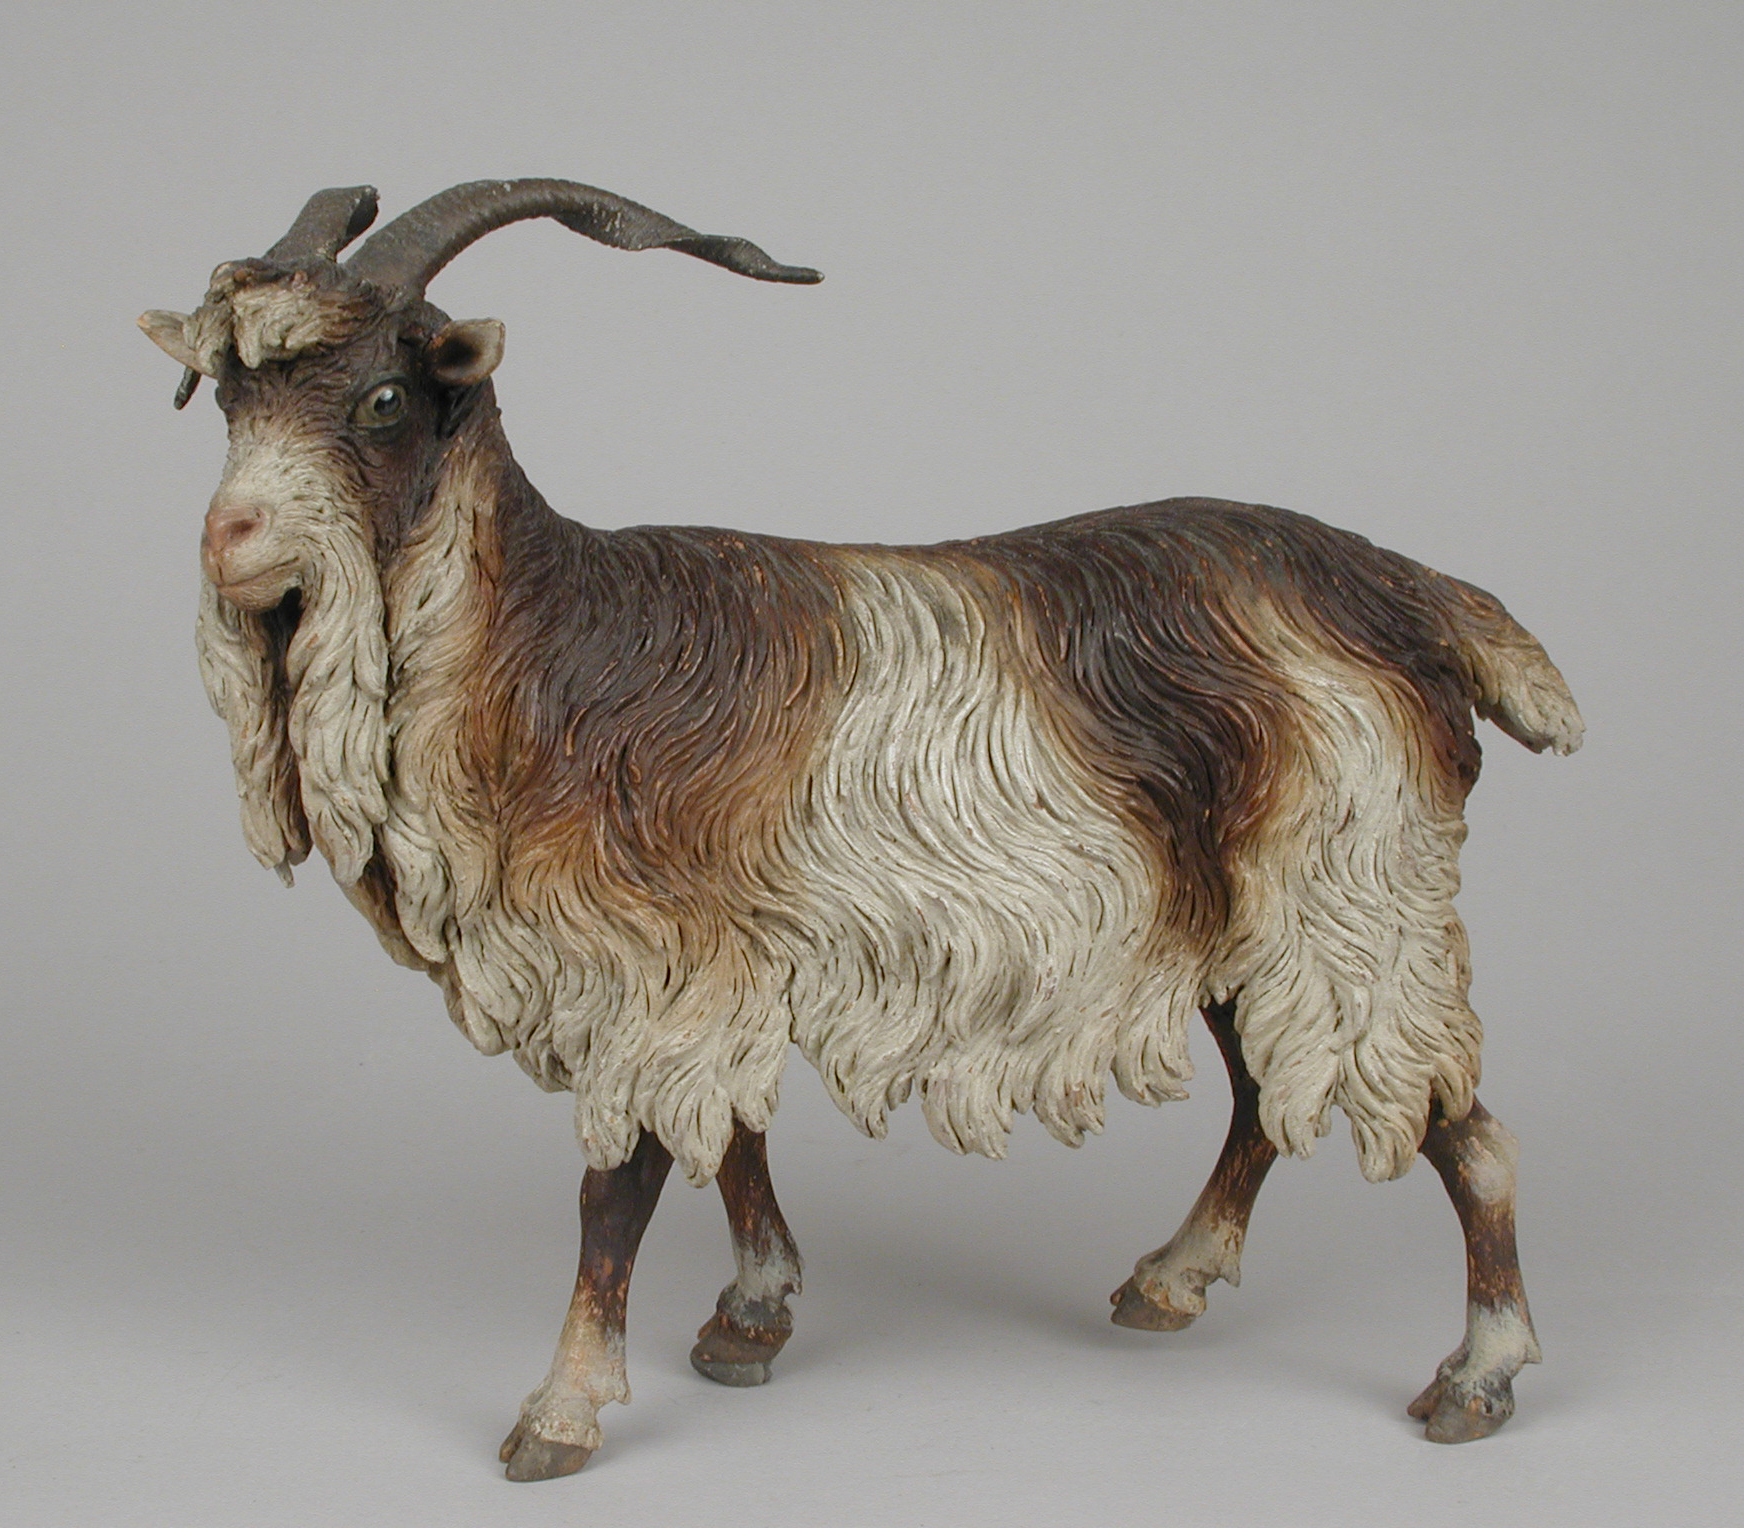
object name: crèche figure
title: Male adult goat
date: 1751-1800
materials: metal, terracotta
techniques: polychrome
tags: goats